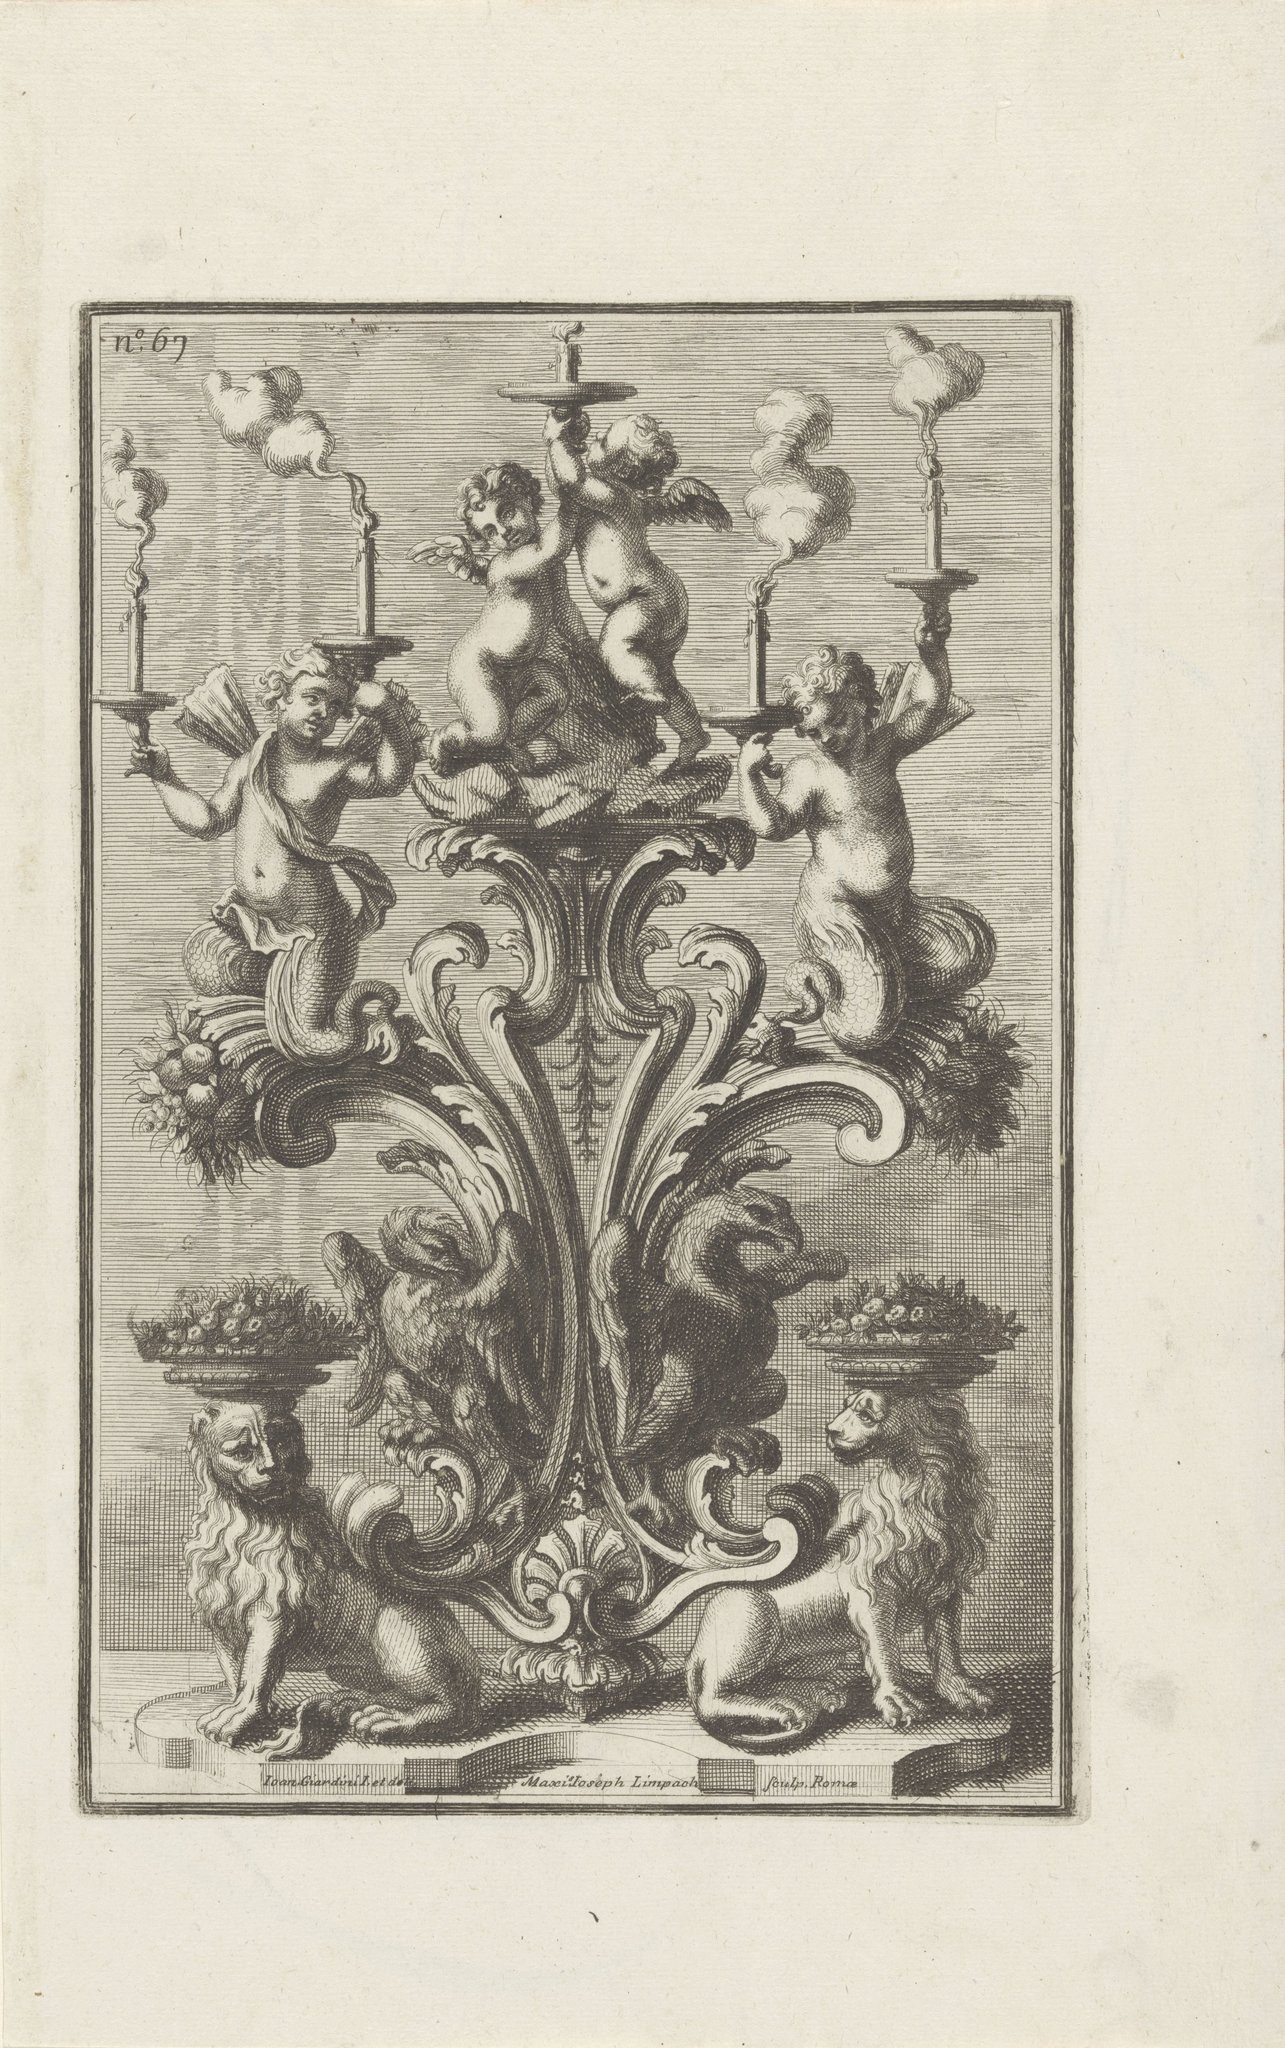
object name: print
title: Disegni diversi inventati e delineati da Giovanni Giardini da Forlì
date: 1714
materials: paper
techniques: etching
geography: vatican city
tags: triton(s), predatory birds: eagle, chandelier, candelabrum, ornament ~ candelabrum, candle, beasts of prey, predatory animals: lion, cupids: 'amores', 'amoretti', 'putti'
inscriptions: collector's mark: Lugt 2228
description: Prent maakt deel uit van een reeks van 100 ornamentprenten naar ontwerp van Giovanni Giardini.